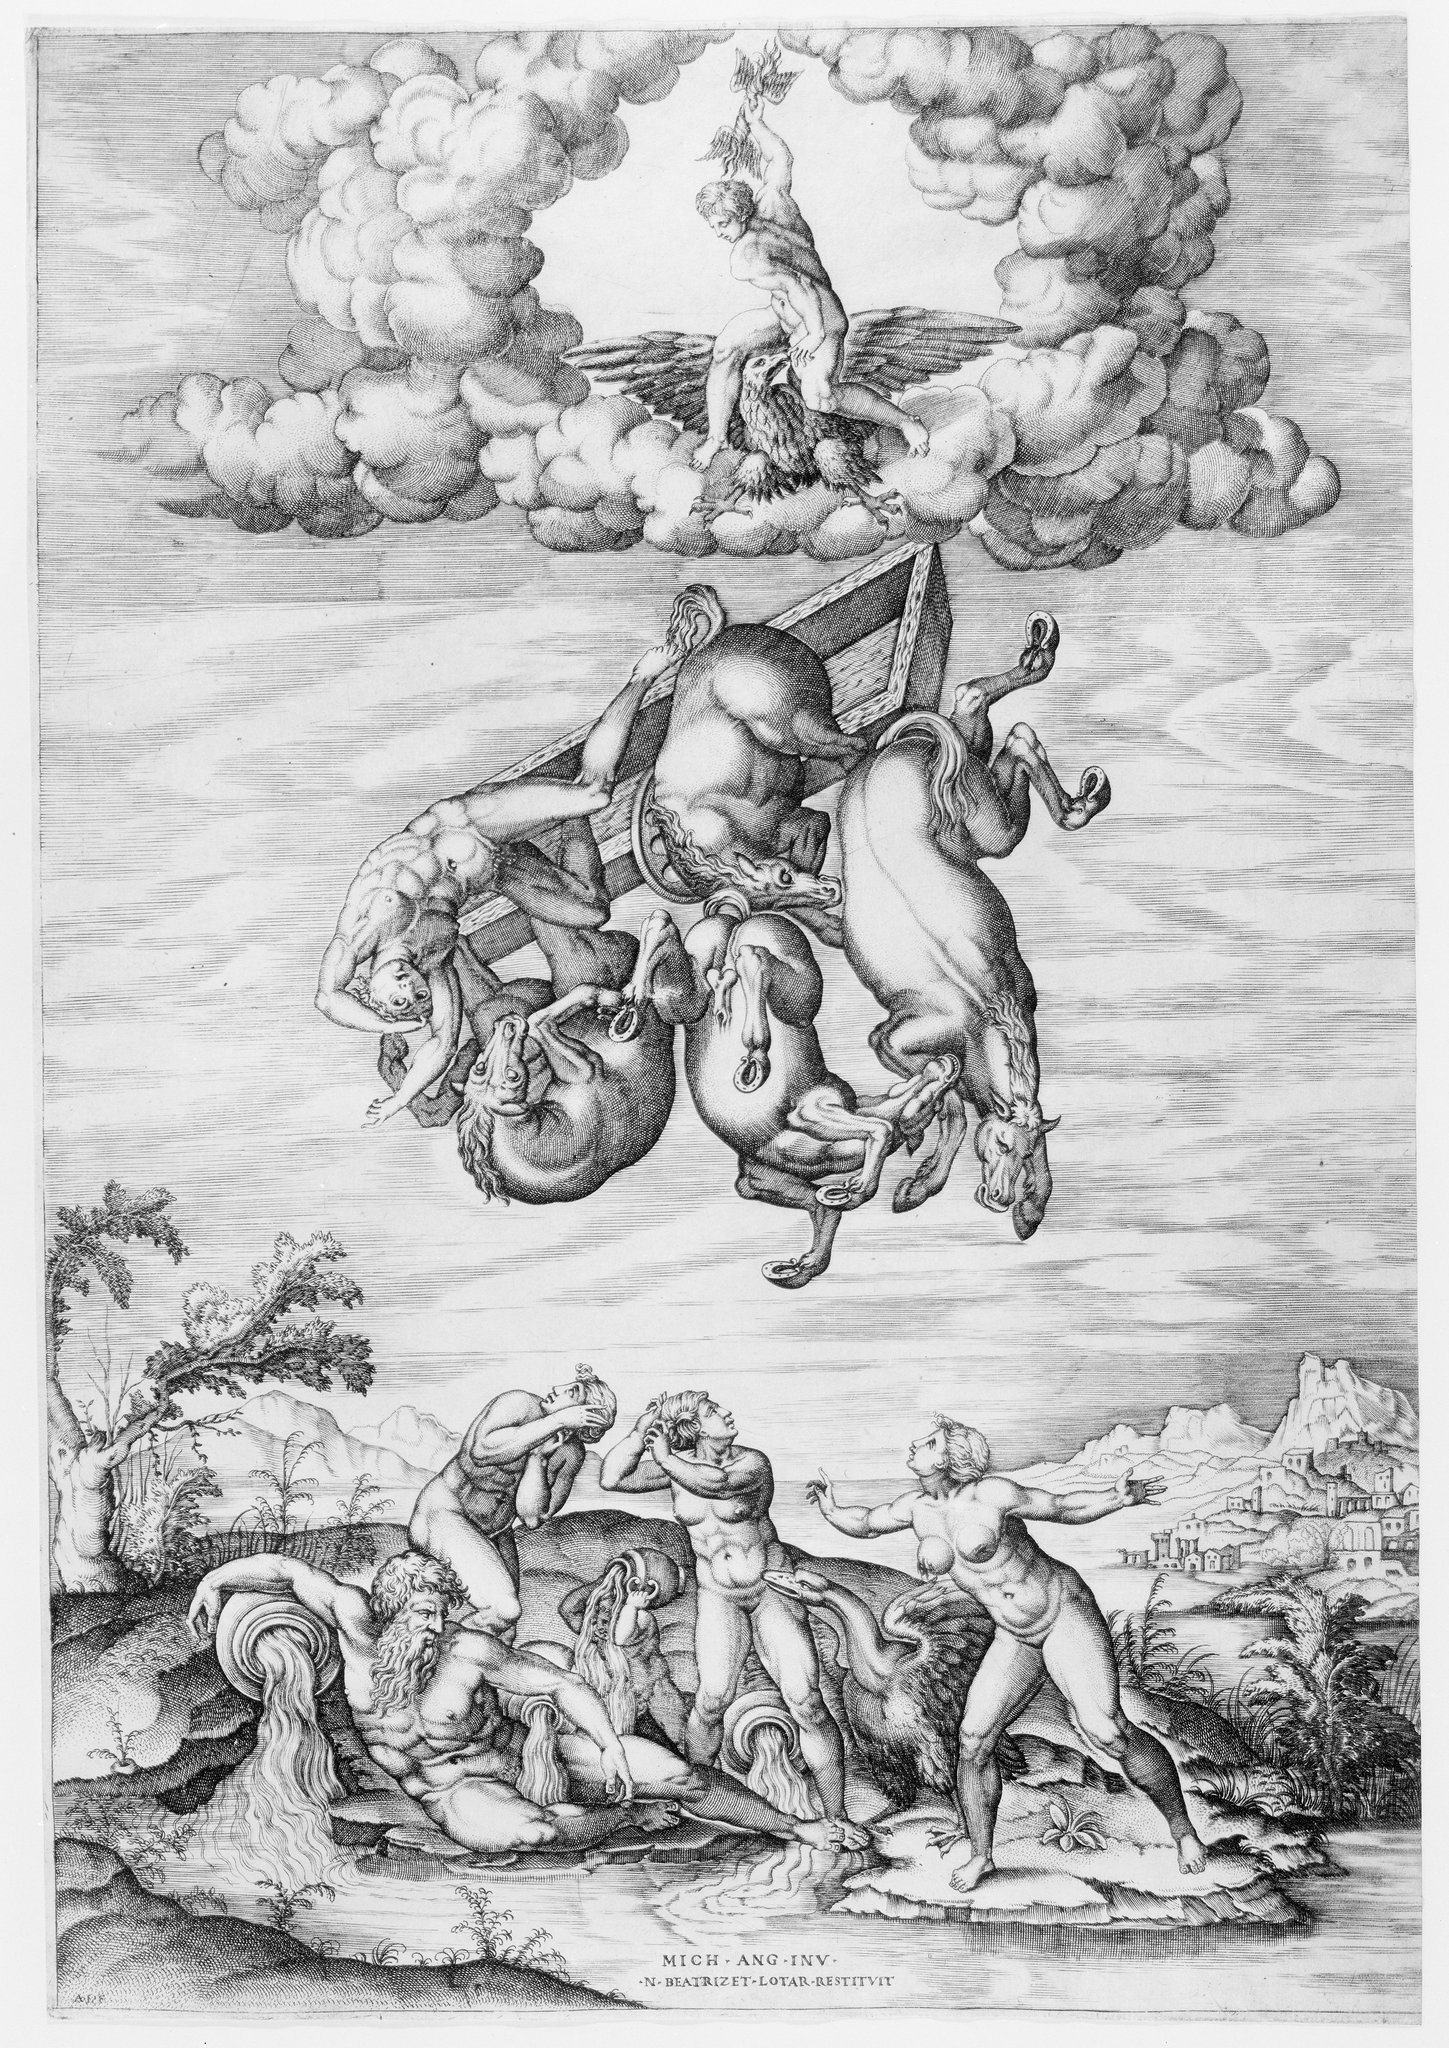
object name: print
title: The Fall of Phaeton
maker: nicolas beatrizet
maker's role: artist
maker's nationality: french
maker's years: 1515-1566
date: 1540-1566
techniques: engraving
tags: male nudes,female nudes,horses